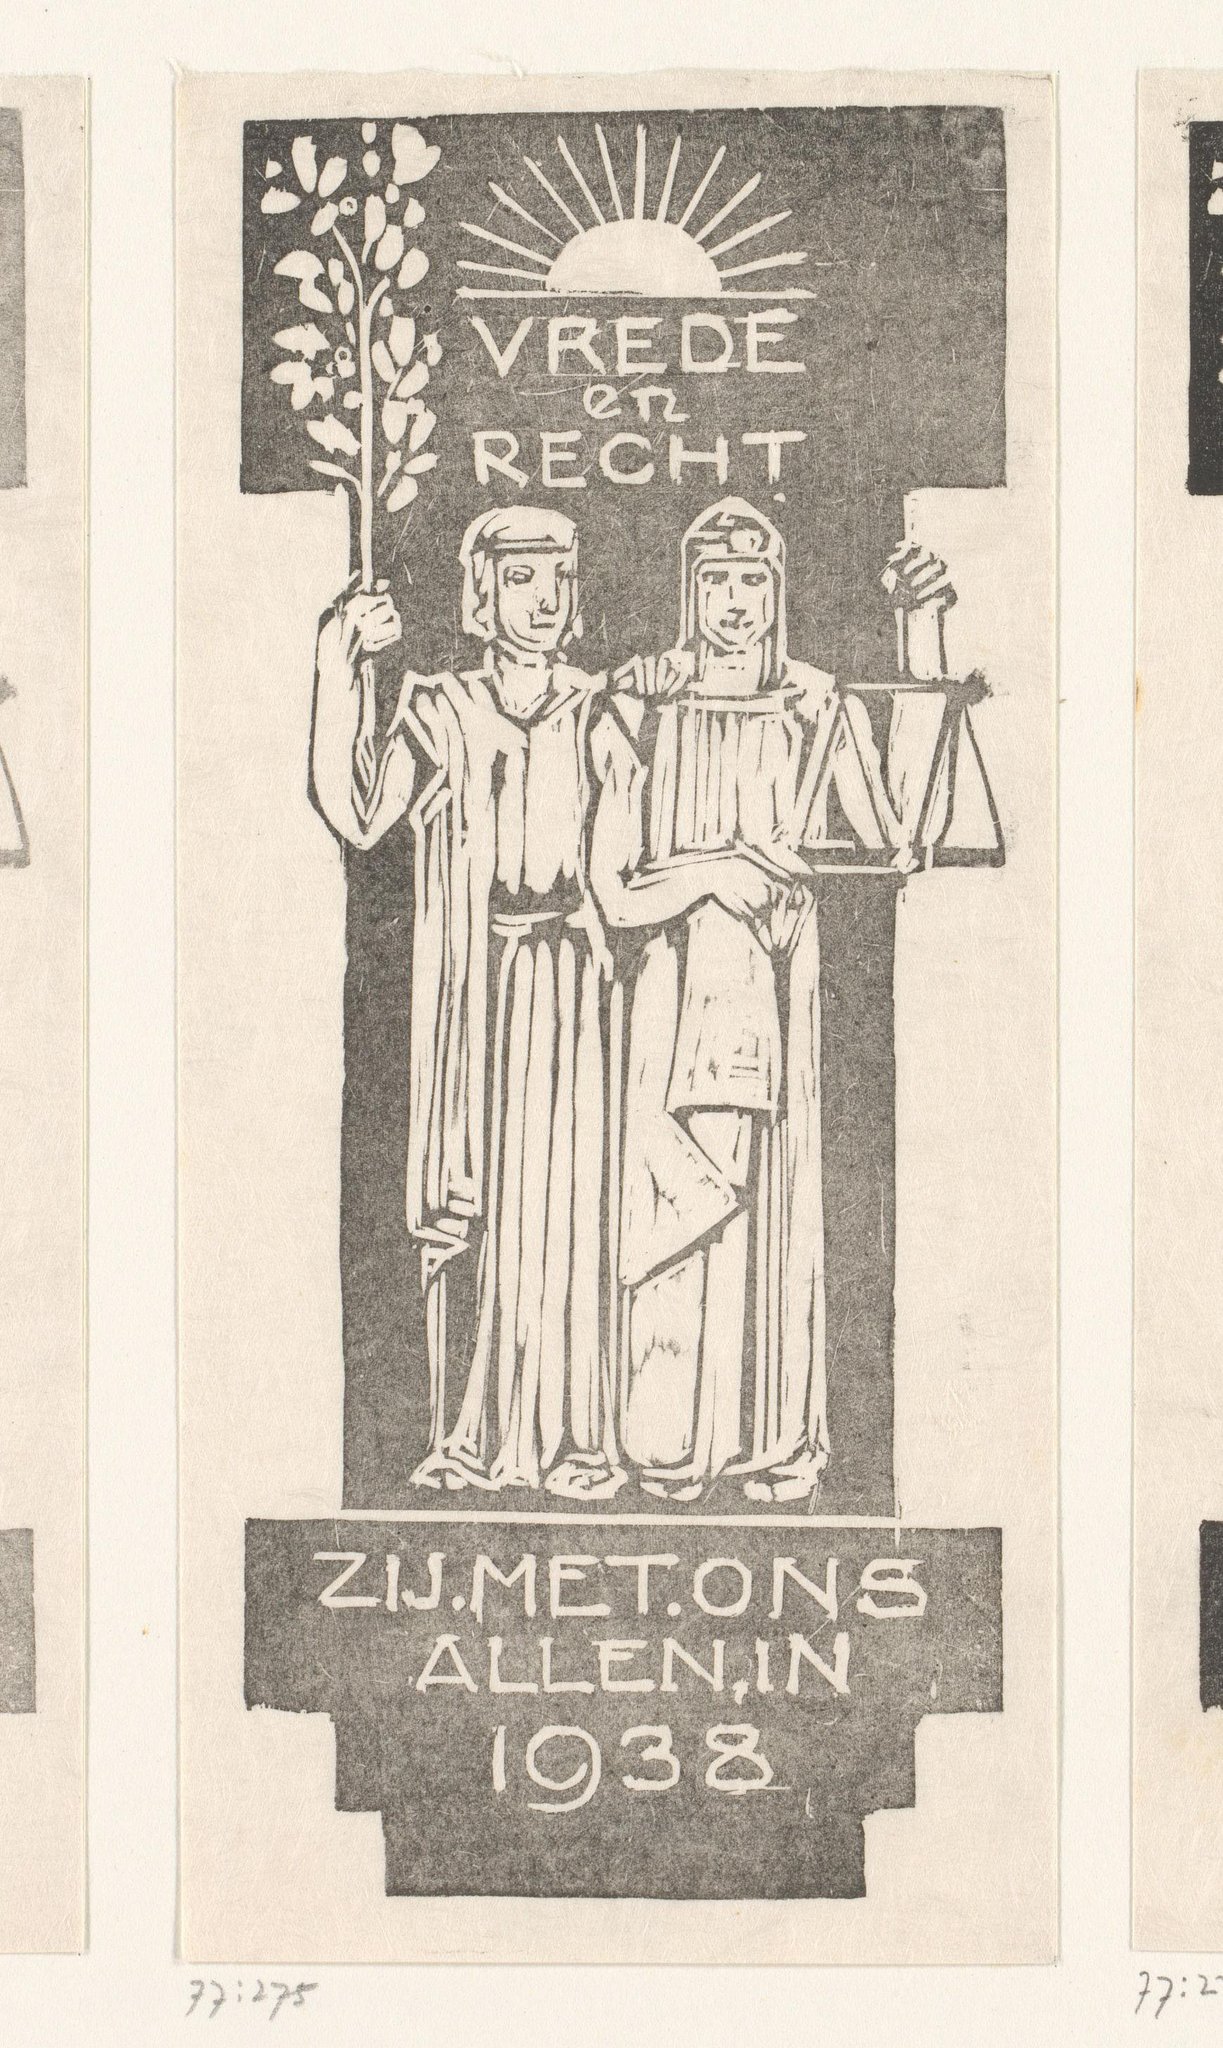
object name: print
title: Nieuwjaarswens voor het jaar 1938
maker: bernard willem wierink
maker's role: draughtsman, print maker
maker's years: 1856-1939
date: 1937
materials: paper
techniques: relief print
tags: symbols, allegories of peace, 'pax'; 'pace' (ripa), new year's eve (december 31), justice; 'forza alla giustitia sottoposta', 'giustitia', 'giustitia retta', 'giustitia rigorosa', 'impietà e violenza soggetta alla giustitia' (ripa)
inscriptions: collector's mark: Lugt 2228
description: Deze prent is waarschijnlijk een plaatsnede, ook al wordt in de literatuur veelal gesproken over een houtsnede. Voor zover Wierink zijn prenten in hoogdruk zelf heeft omschreven, heeft hij altijd de term 'plaatsnede' gebruikt.